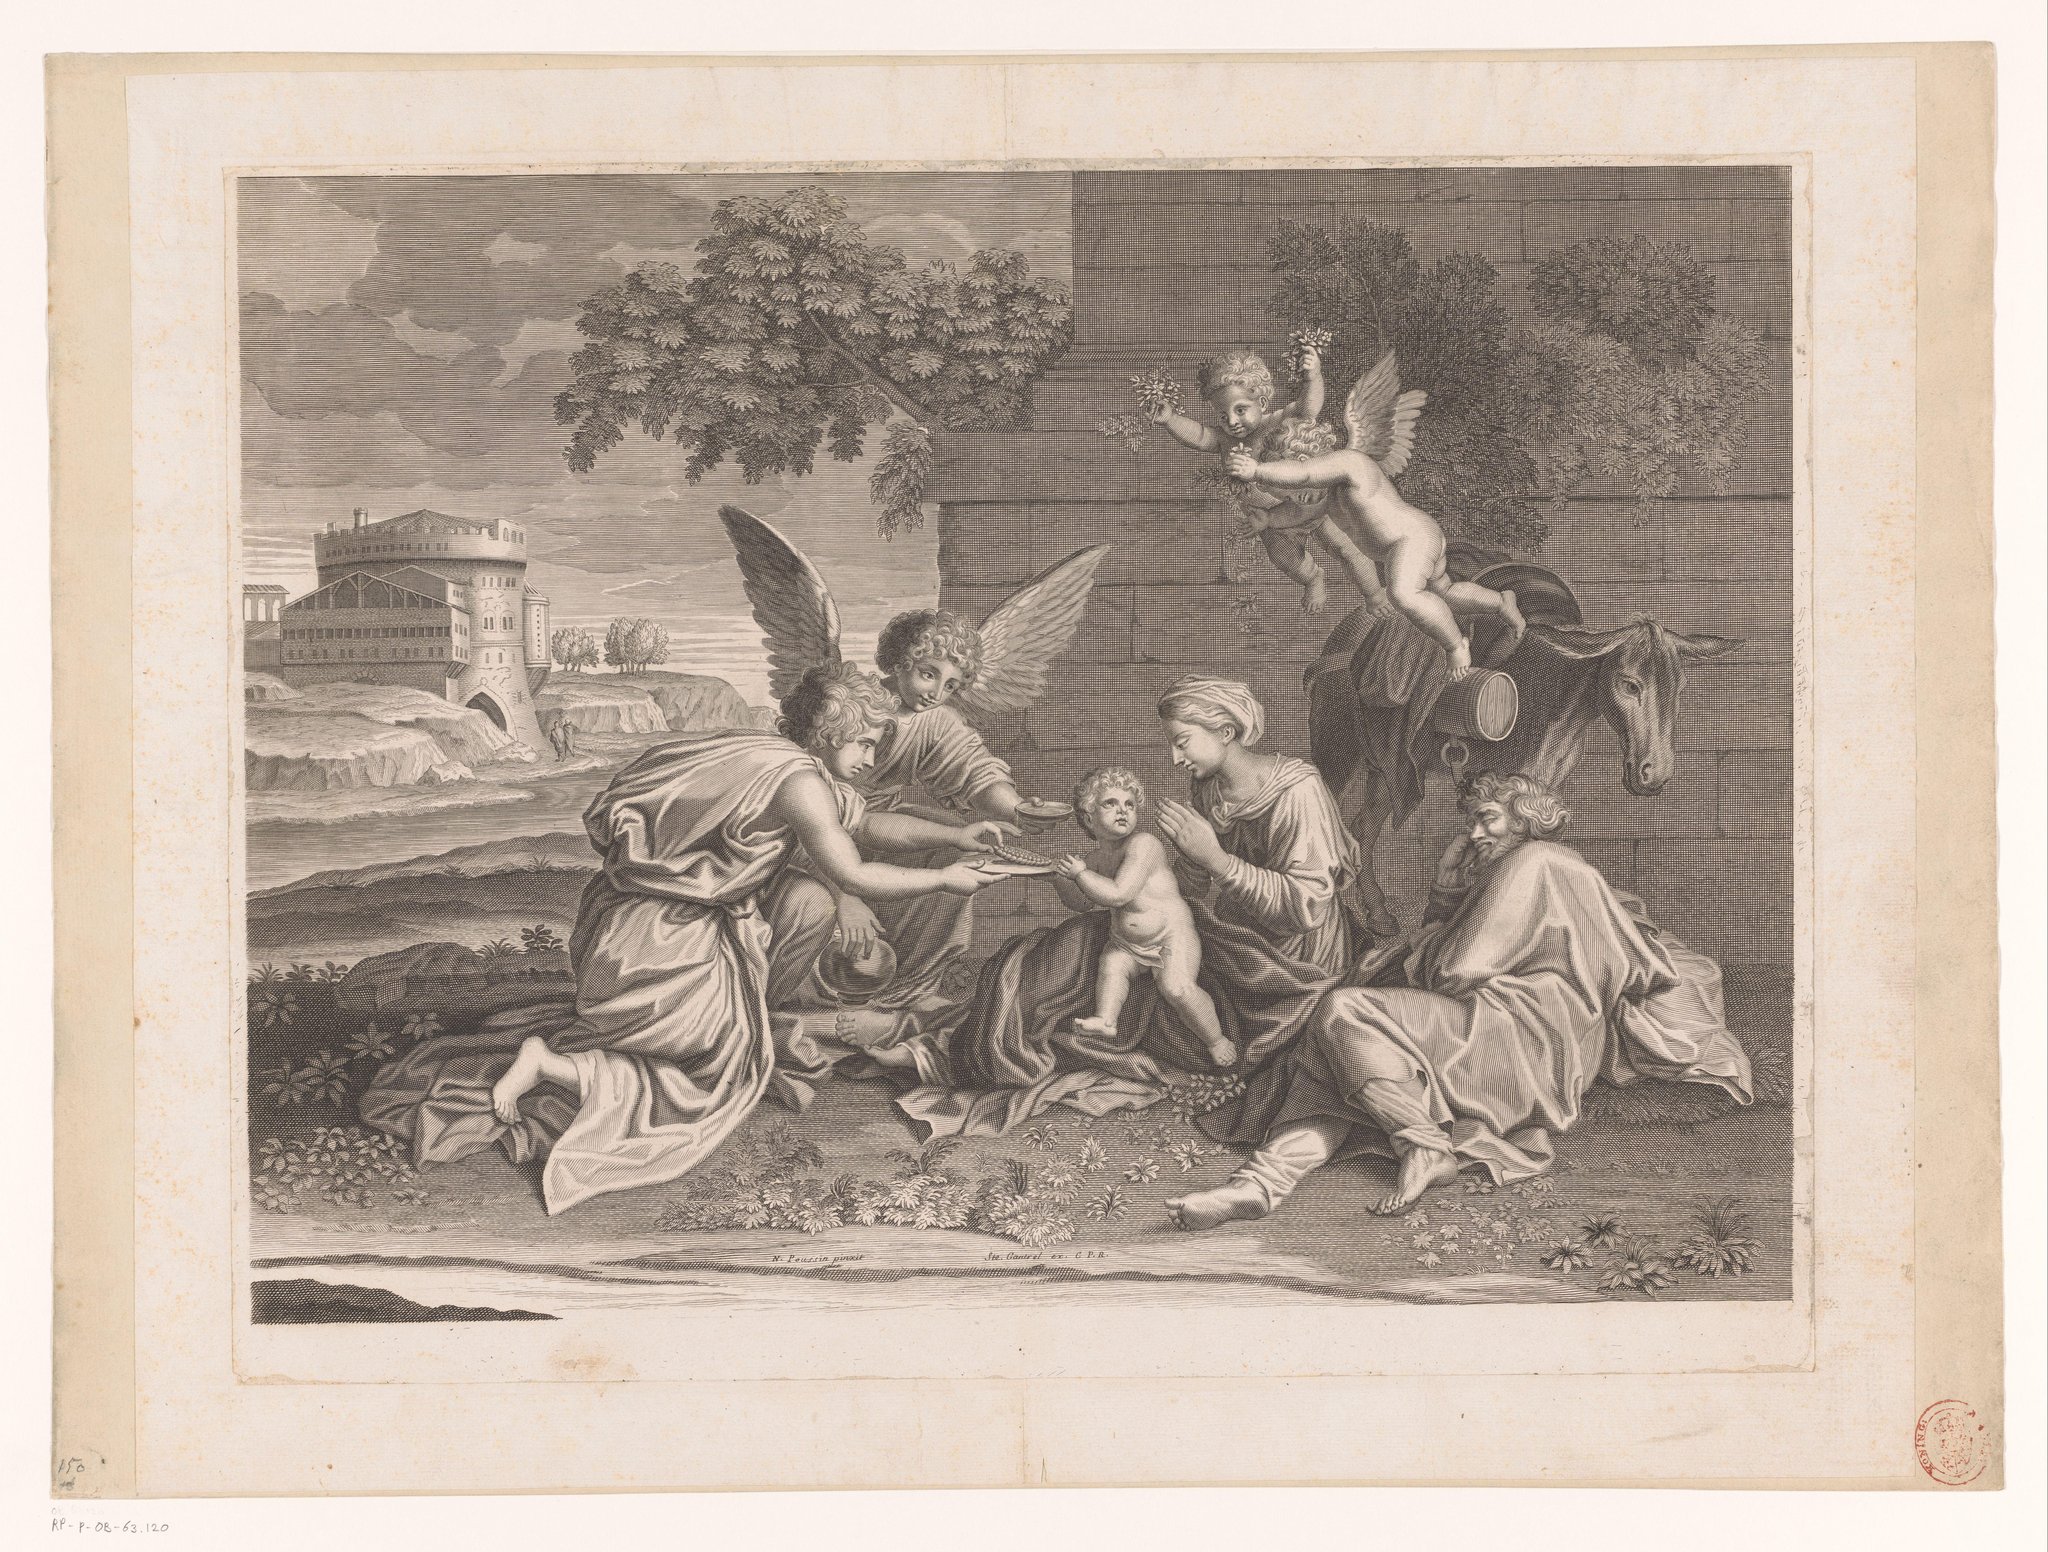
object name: print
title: Heilige Familie met engelen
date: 1656-1706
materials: paper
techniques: engraving, etching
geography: france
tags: holy family, and derived representations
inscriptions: number: ‘16’, collector's mark: Lugt 240